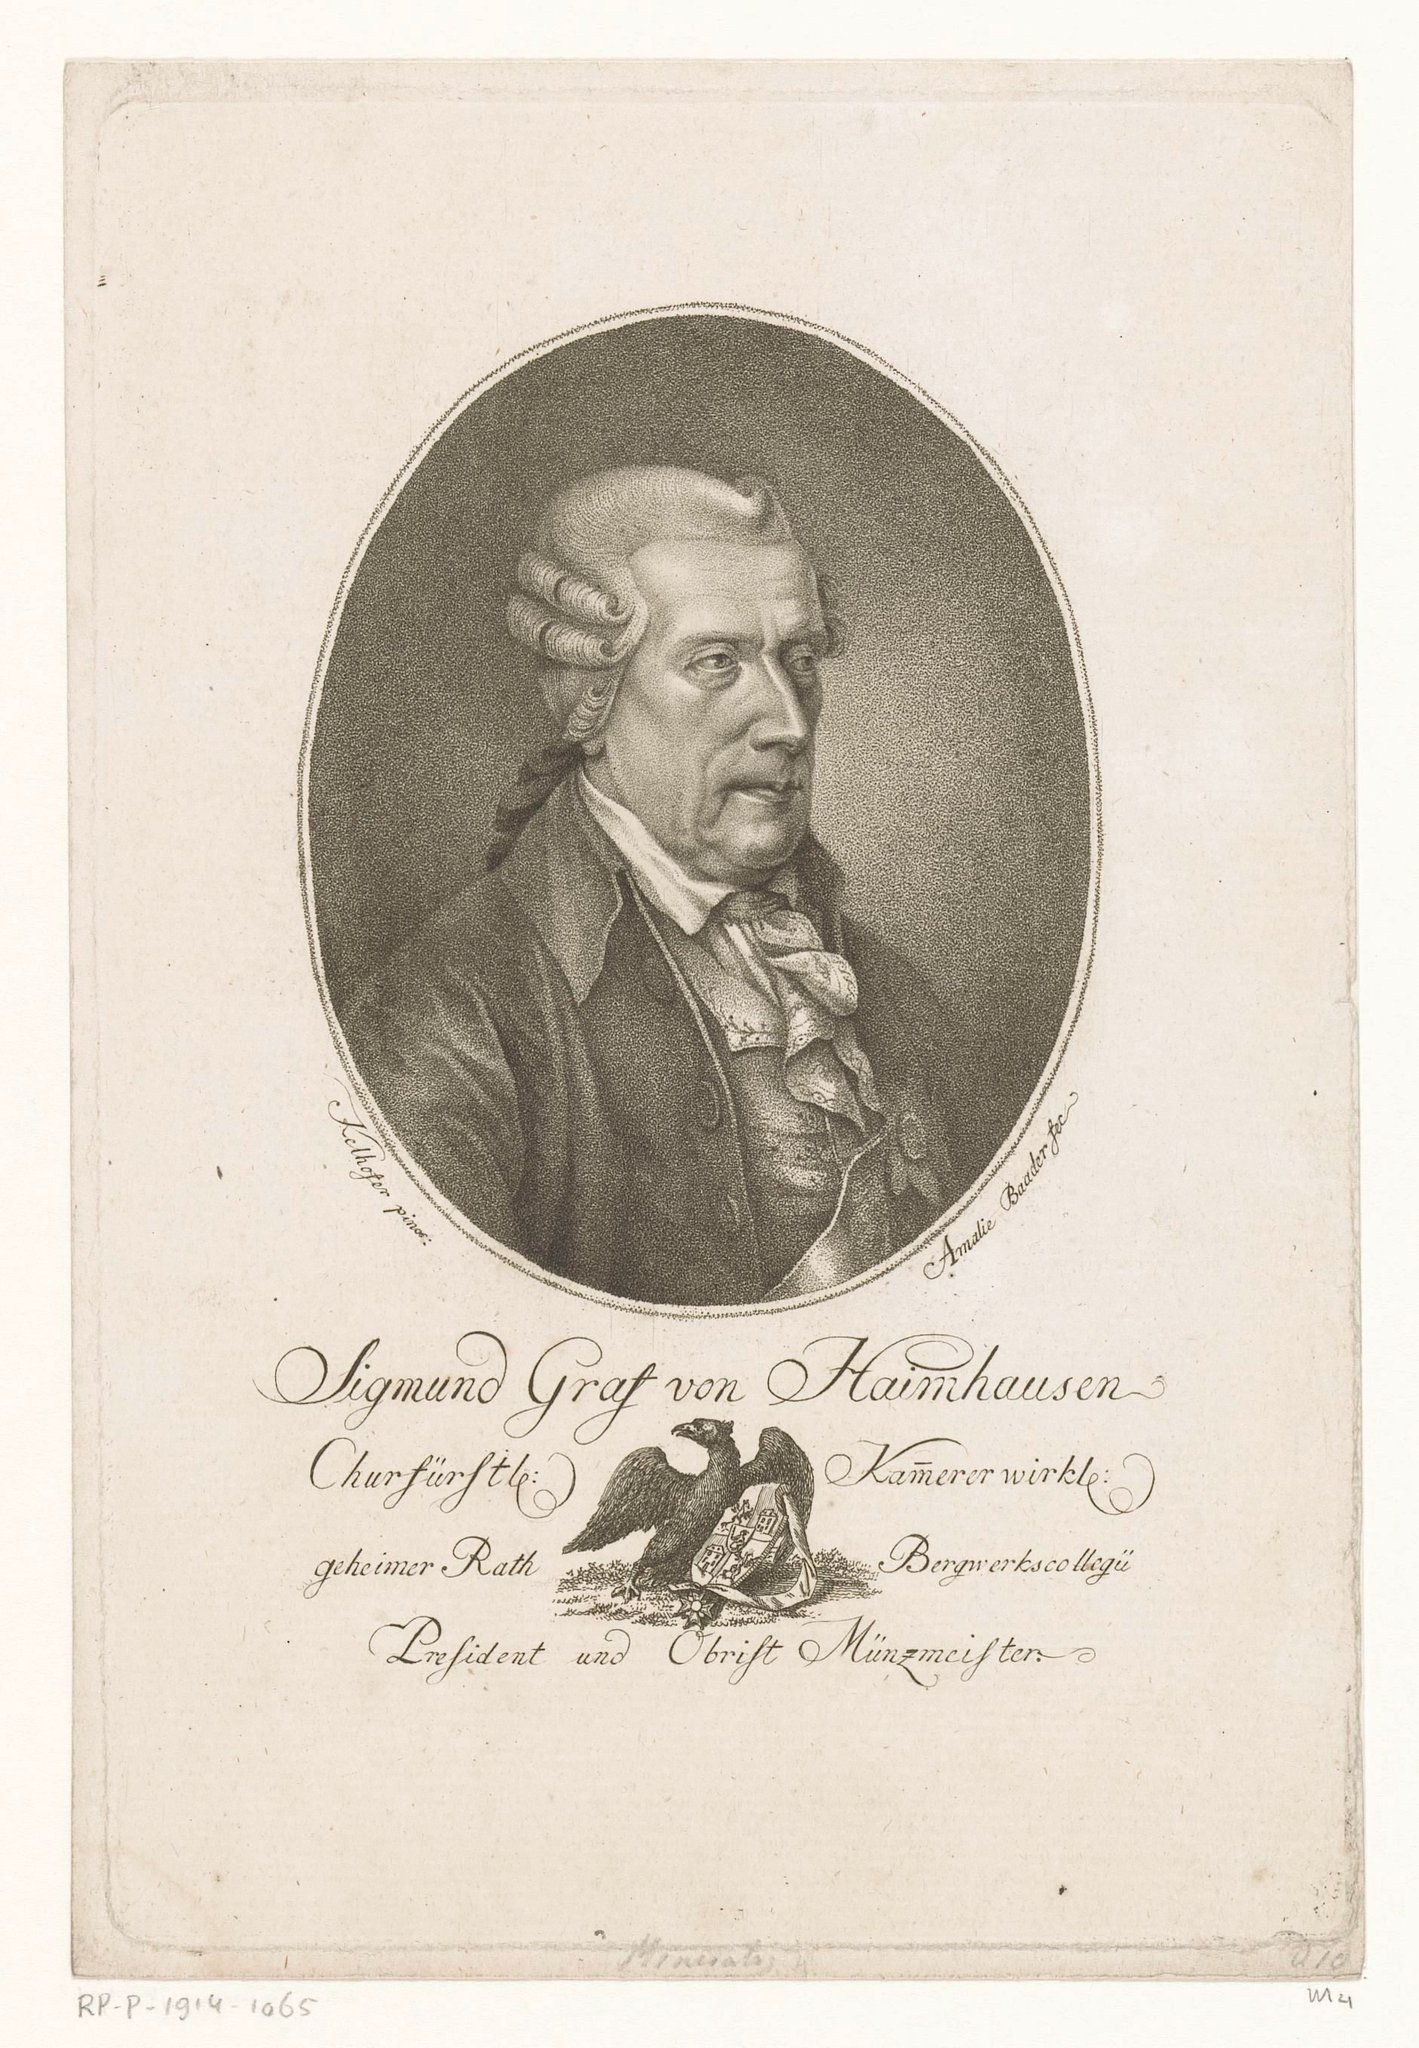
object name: print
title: Portret van Sigmund von Haimhausen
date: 1773-1840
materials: paper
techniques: etching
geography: germany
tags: sigmund graf von haimhausen, historical persons, armorial bearing, heraldry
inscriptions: collector's mark: Lugt 2228